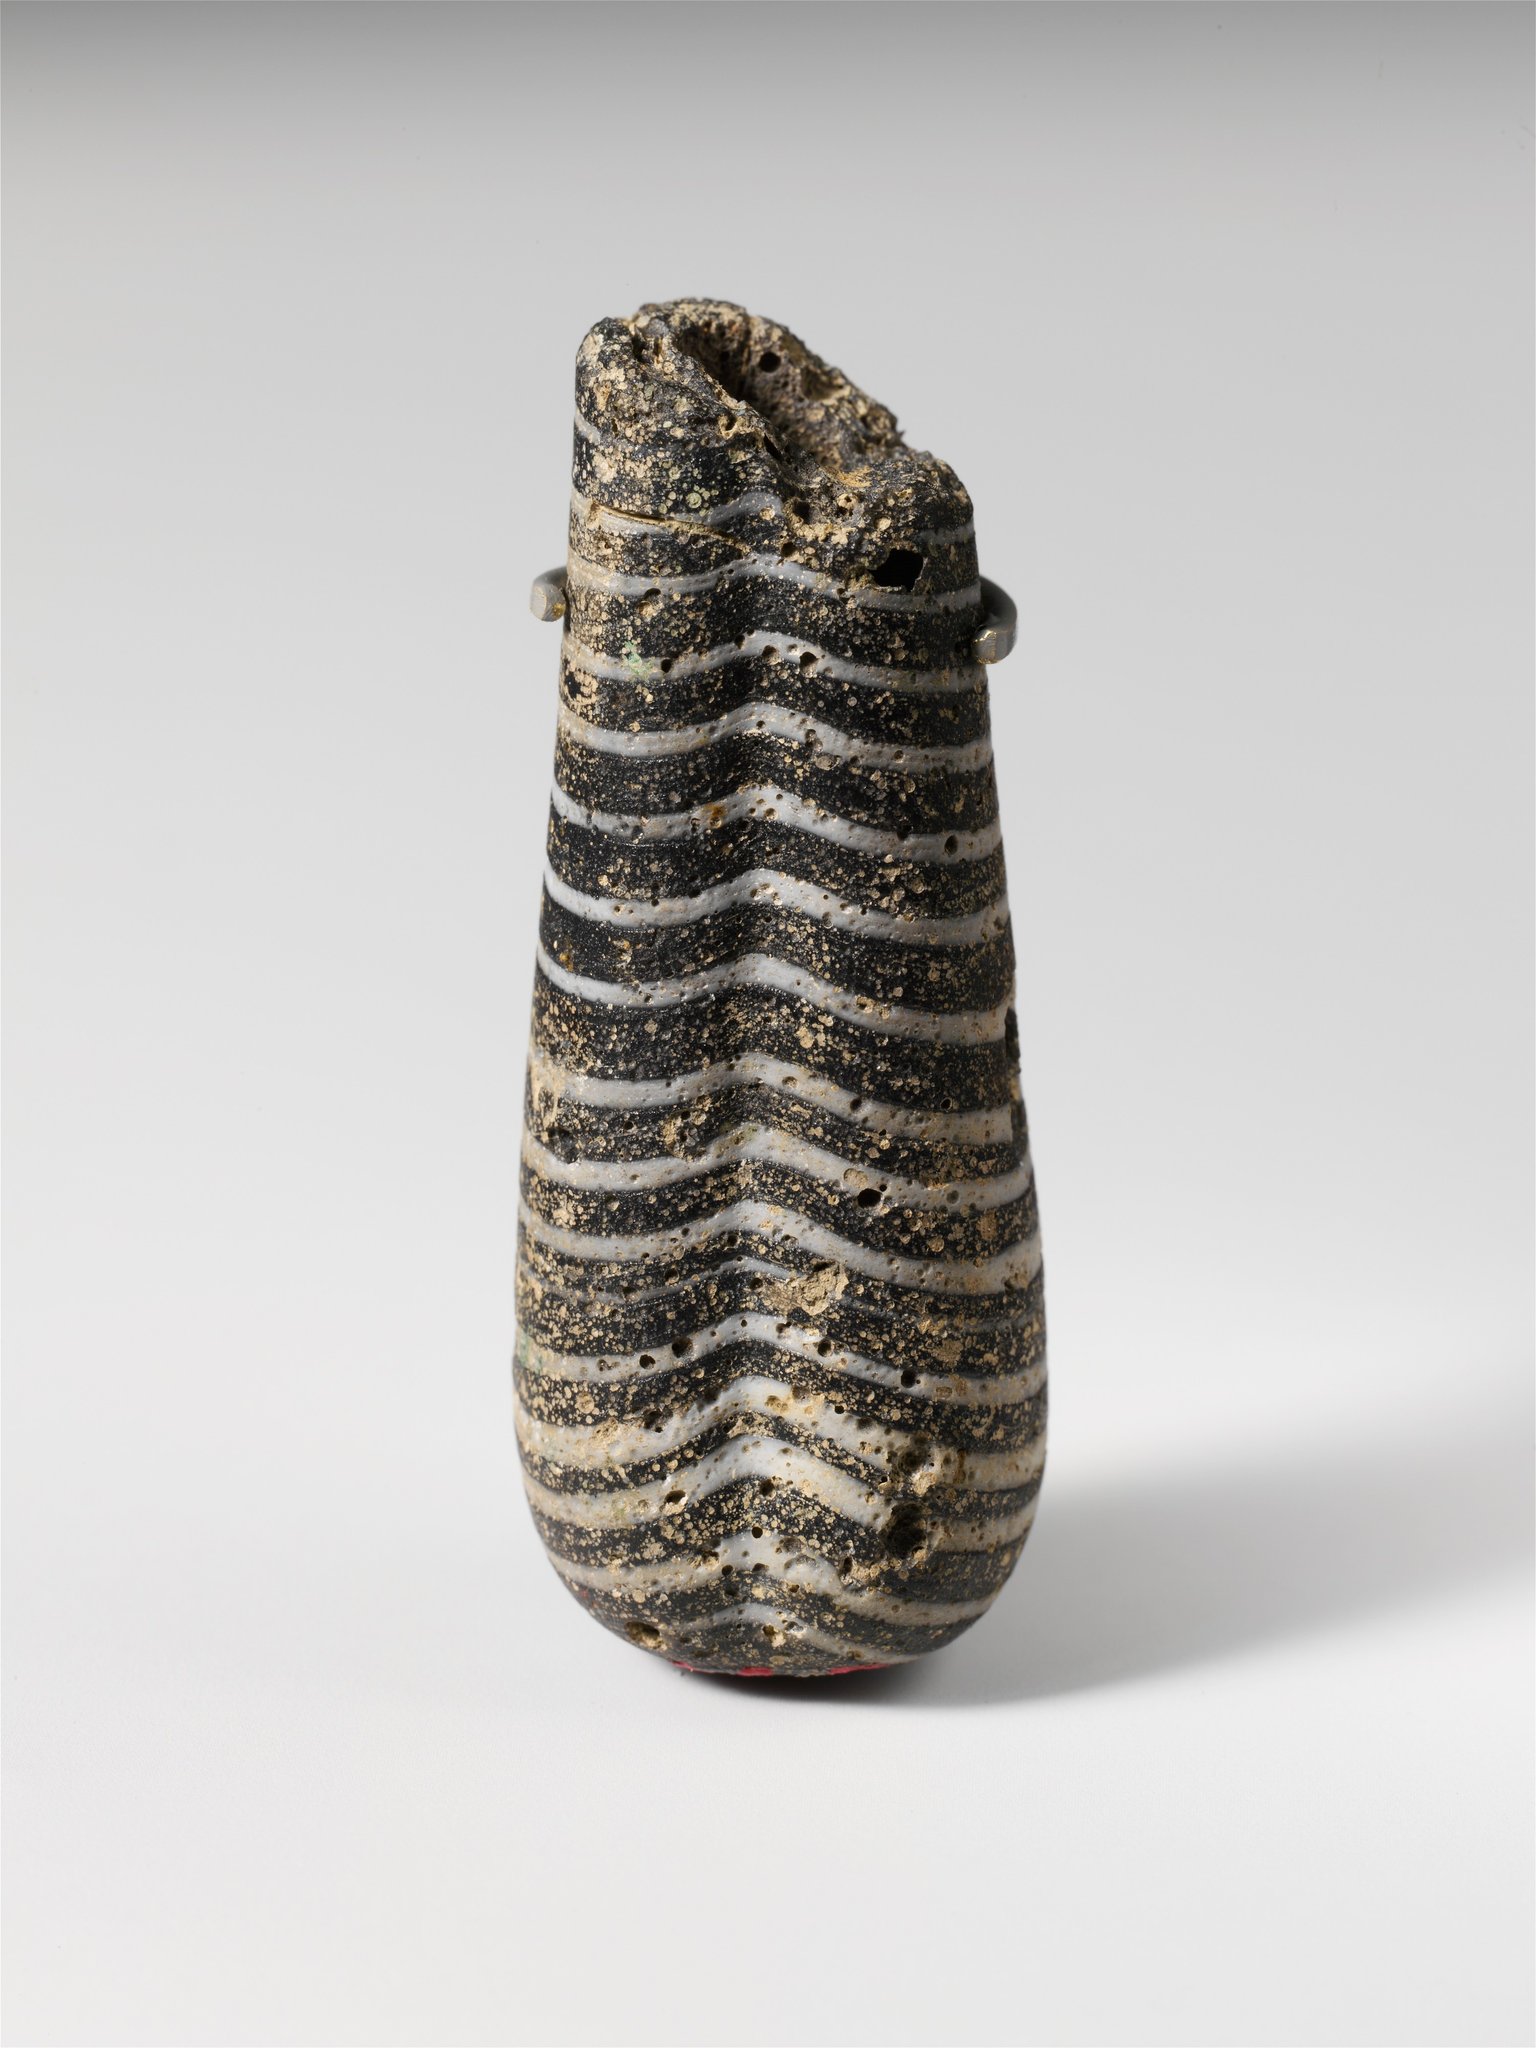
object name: plumbline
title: Glass pendant bead in the shape of a plumbline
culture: etruscan or greek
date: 700-401 BCE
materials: glass